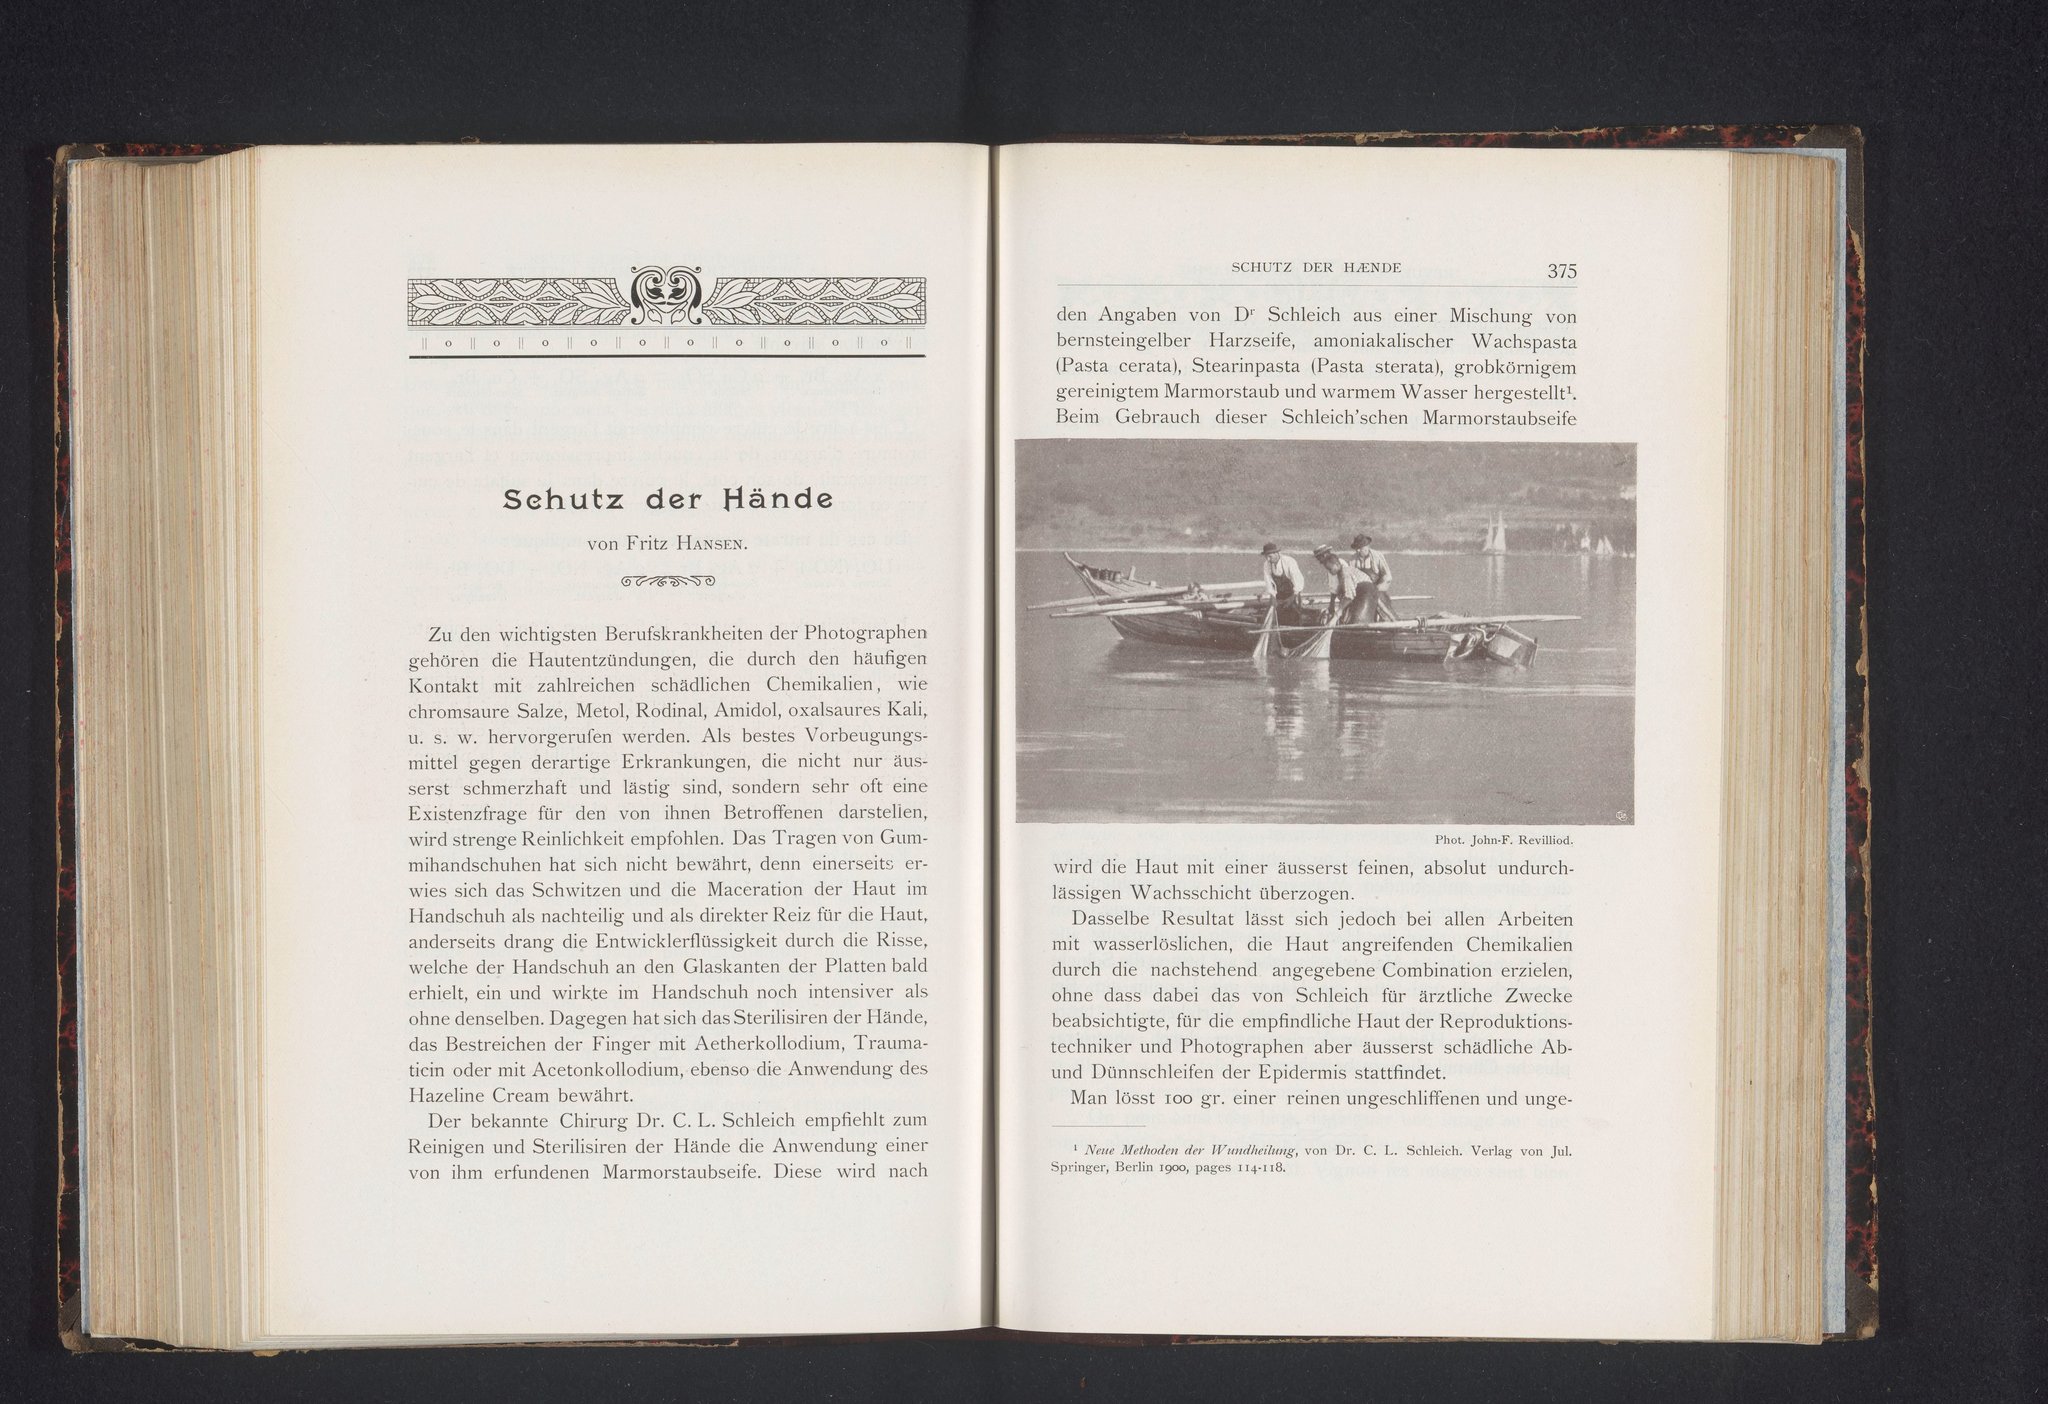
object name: photomechanical print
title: Vissers op het meer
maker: john f. revilliod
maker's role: fotograaf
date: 1897-1902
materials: paper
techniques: autotype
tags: rowing-boat, canoe, etc., lake, fisherman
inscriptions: monogram: ‘C. Cie’